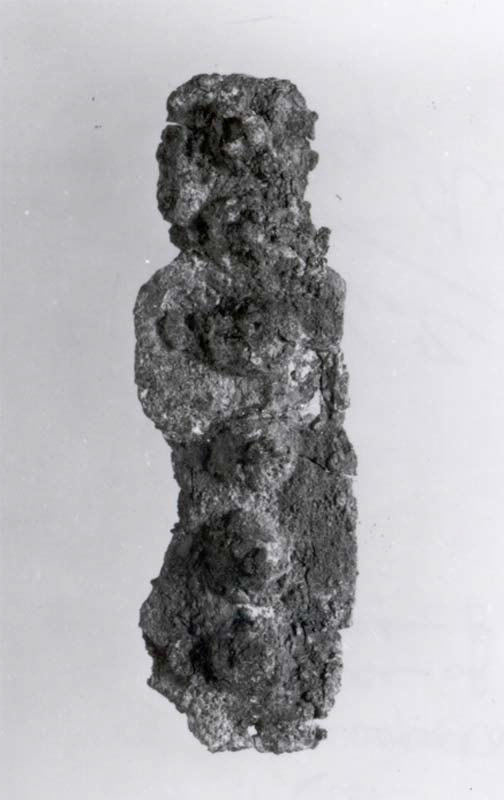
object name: armor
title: Armor plate (?)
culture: assyrian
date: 734-601 BCE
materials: iron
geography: mesopotamia